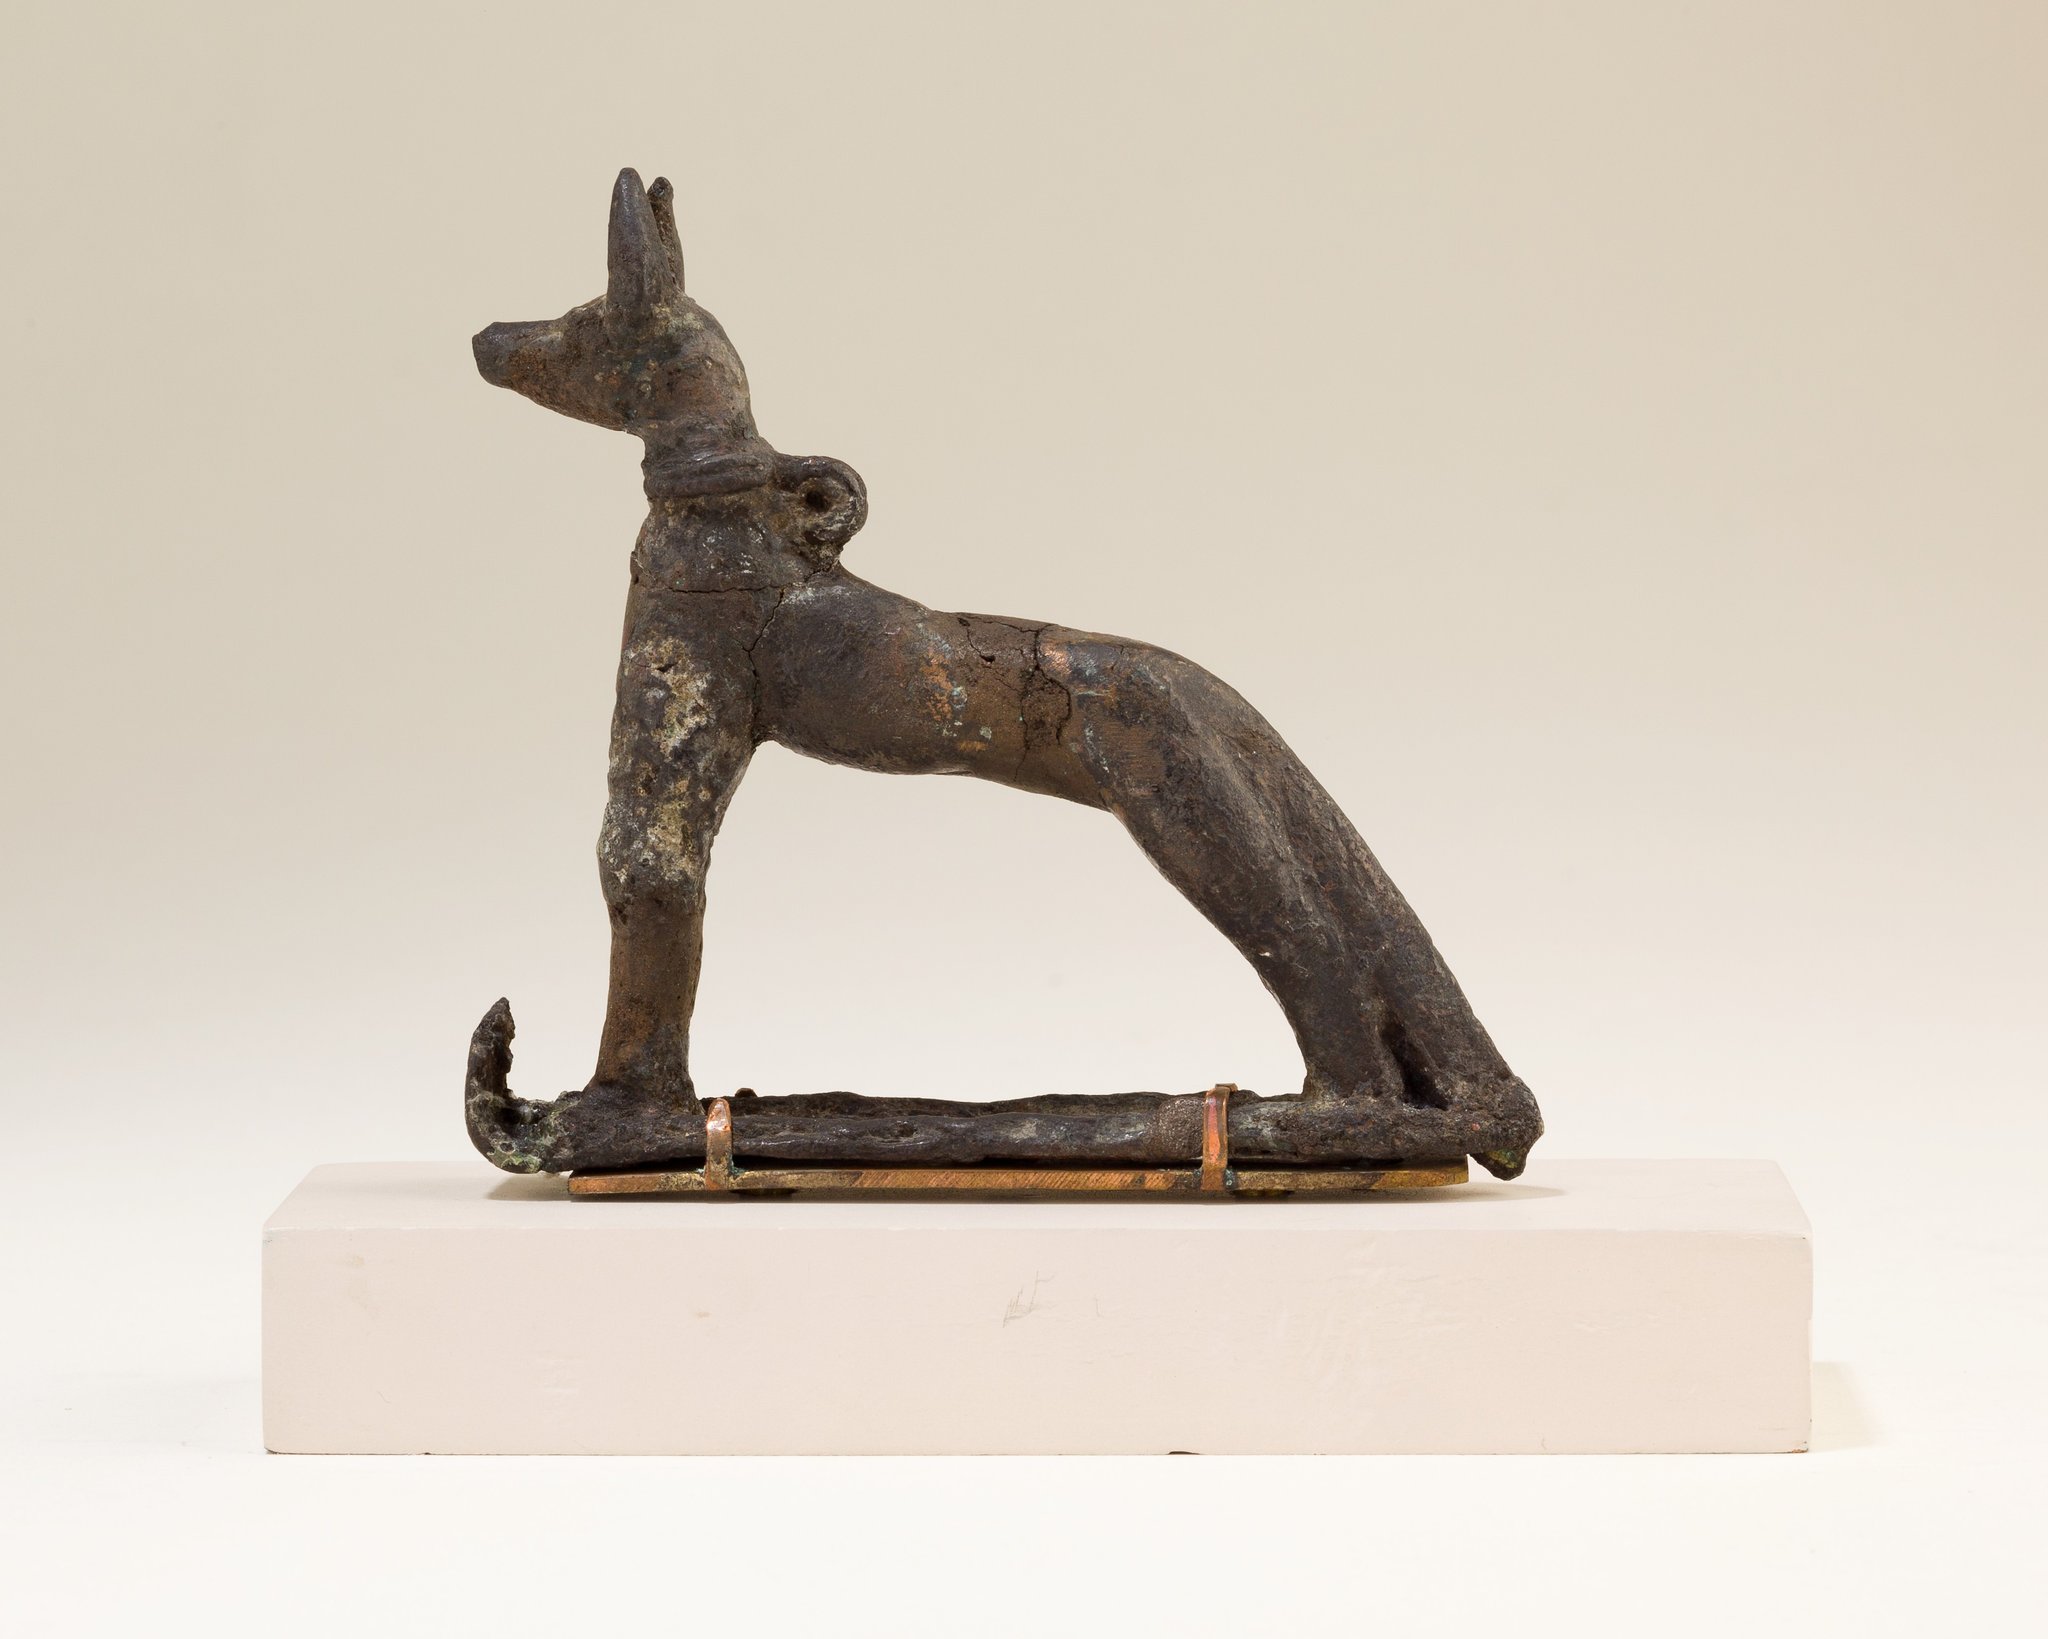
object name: figurine, jackal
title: Jackal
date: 664-630 BCE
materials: metal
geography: egypt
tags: jackals